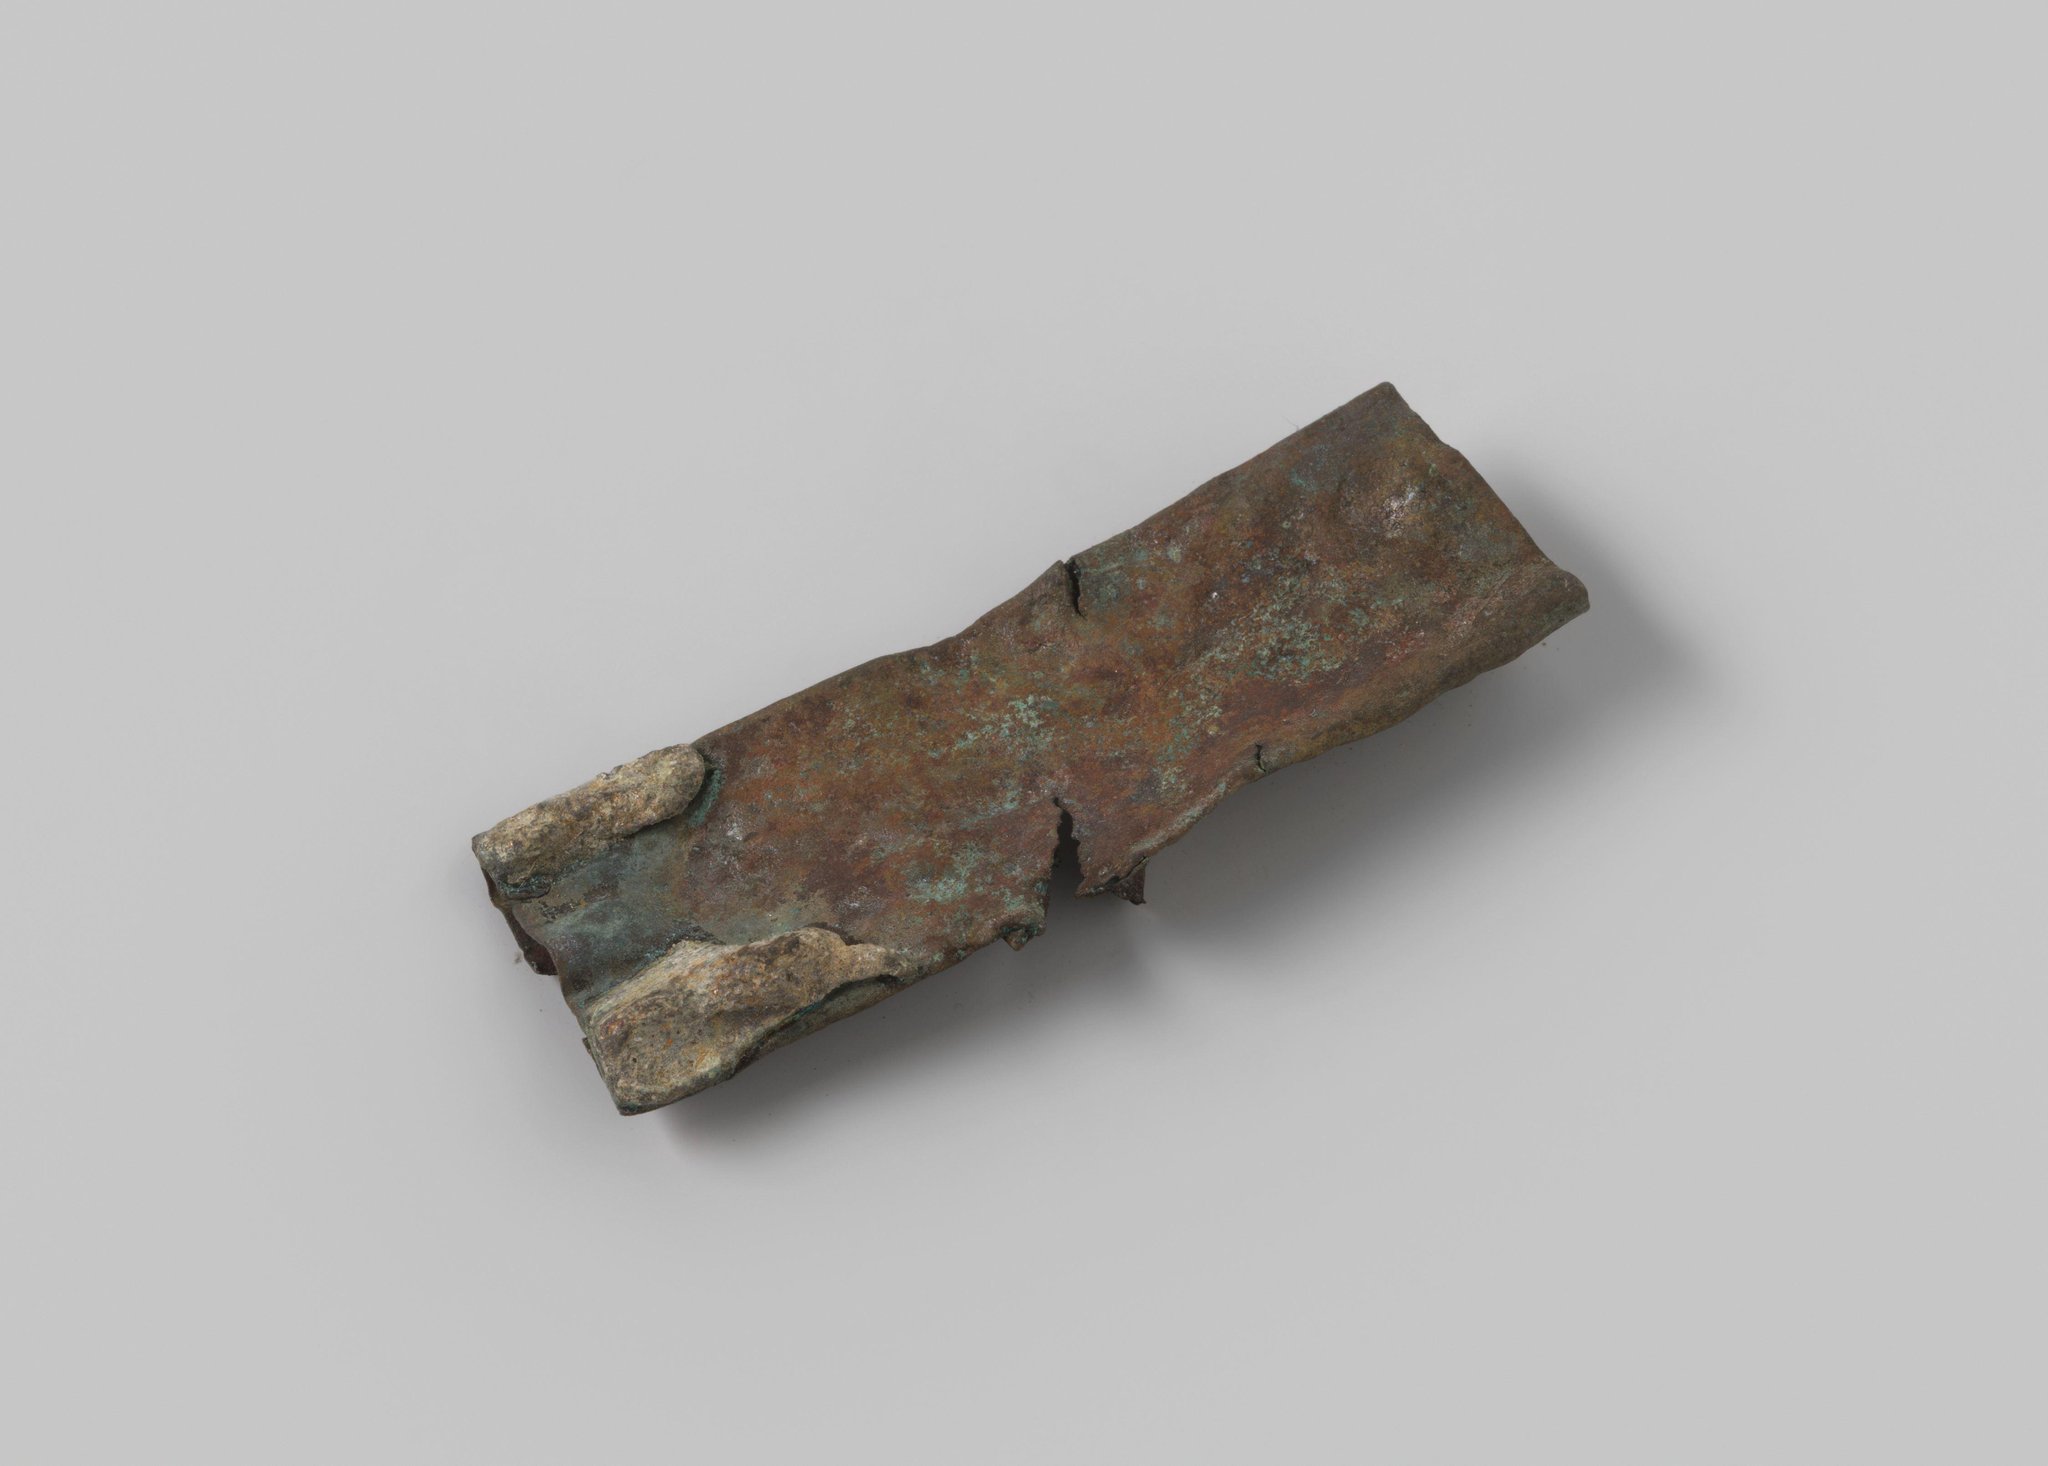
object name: cartridge shell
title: Patroonhuls met beslag uit het wrak van de Oost-Indiëvaarder Hollandia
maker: Anonymous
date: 1700-1743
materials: copper, lead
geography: netherlands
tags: verenigde oostindische compagnie, hollandia (schip), annet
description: Cartridge case, tube; squashed, bent, id. NG 1979-205H549, with lead solder fragm.